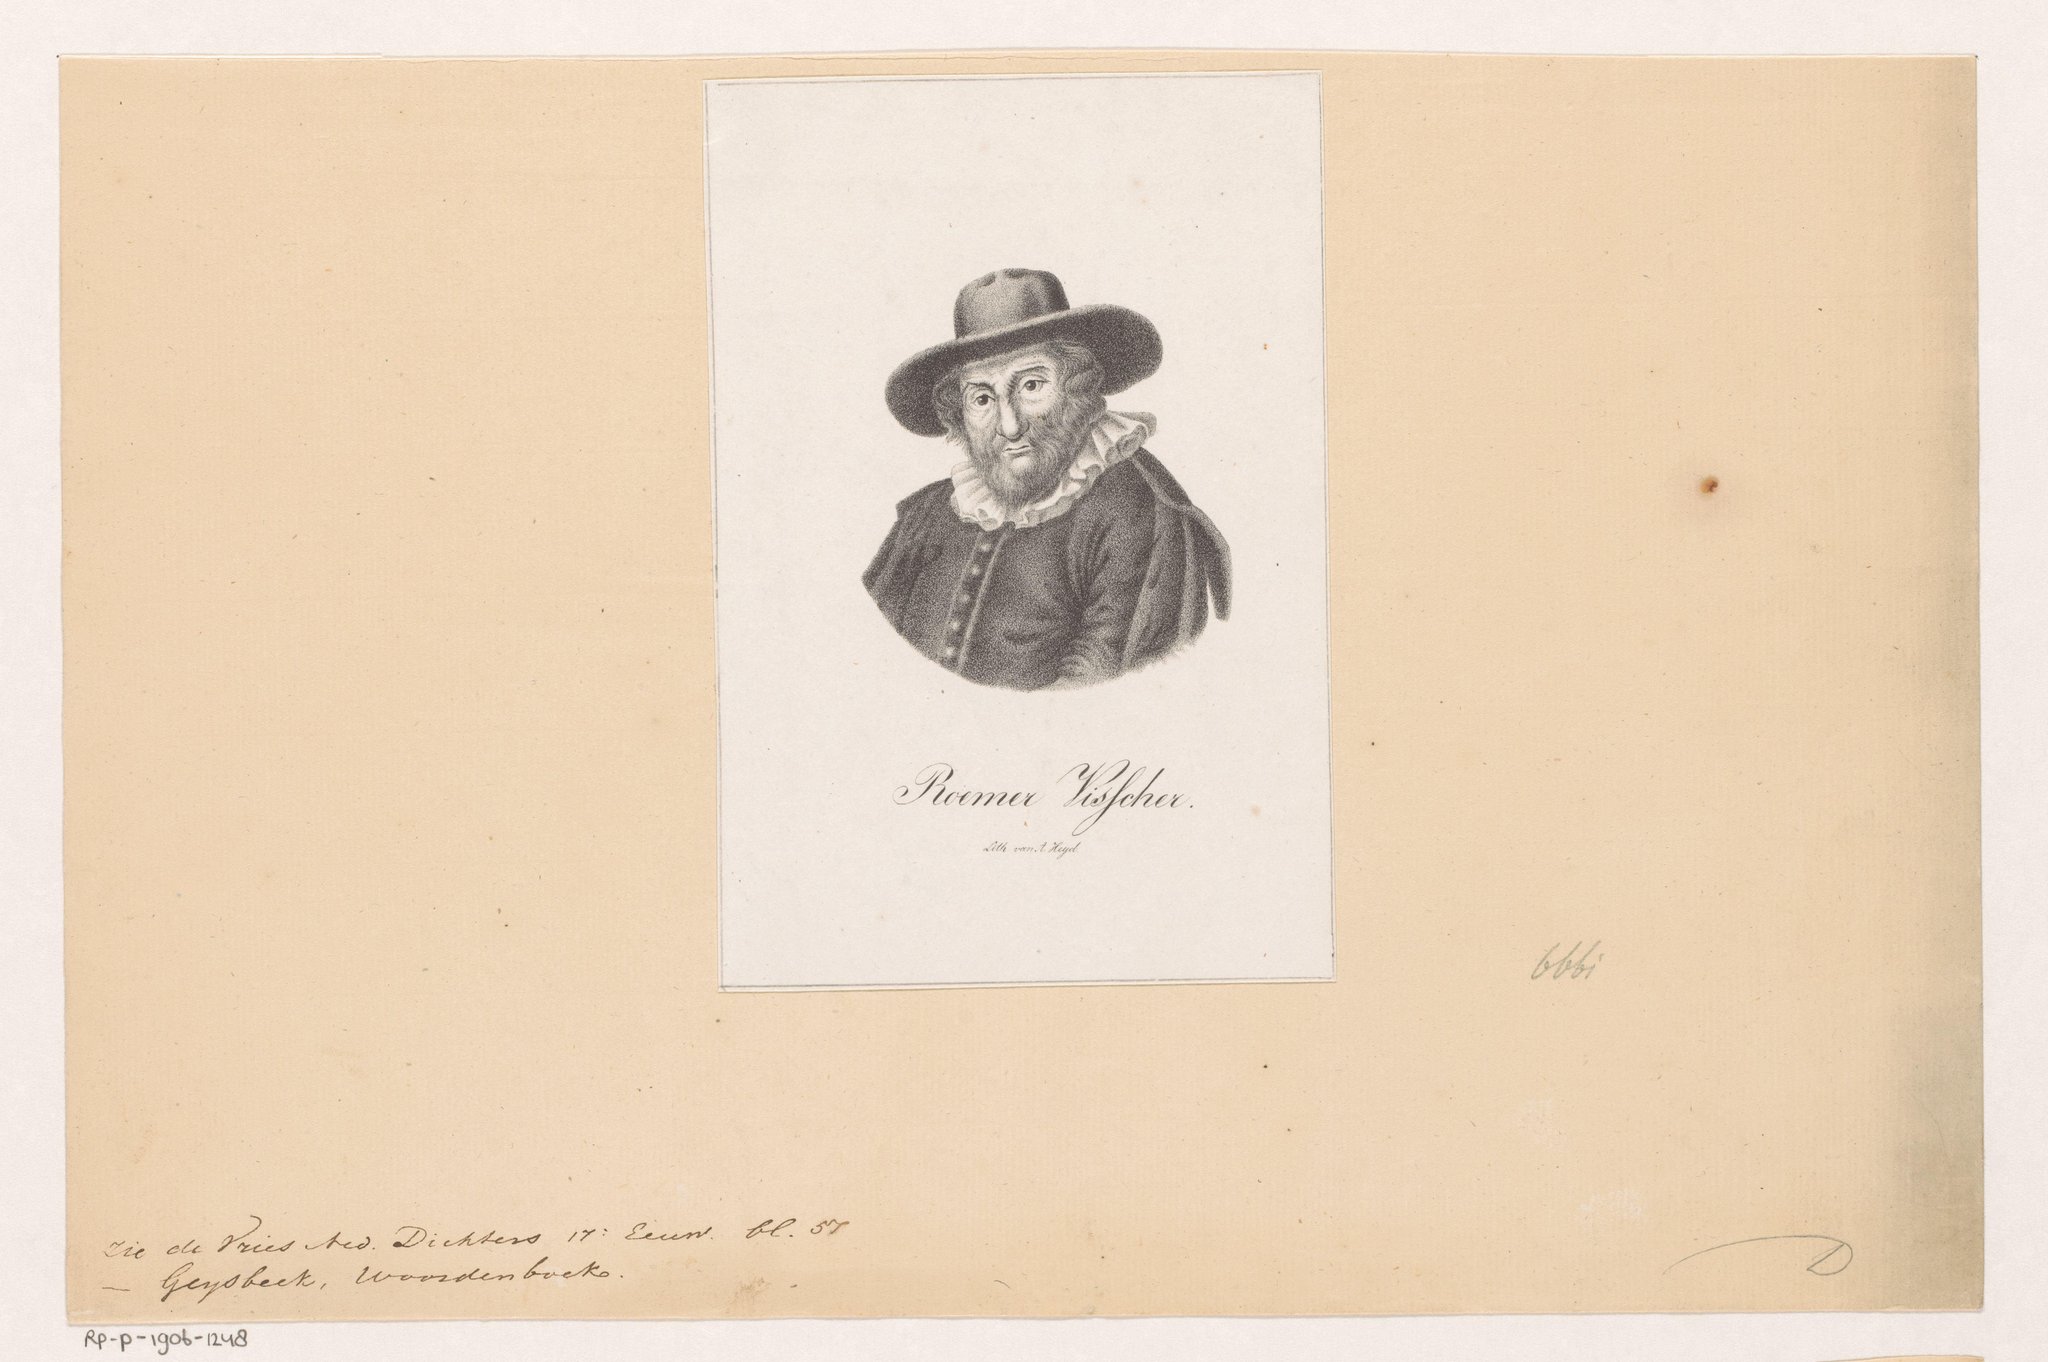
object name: print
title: Portret van Roemer Visscher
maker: a. heyd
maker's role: print maker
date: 1827-1828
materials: paper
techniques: lithograph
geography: amsterdam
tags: roemer visscher, historical persons (+ (full) bust portrait)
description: De geportretteerde draagt een hoed. Onder het portret zijn naam.